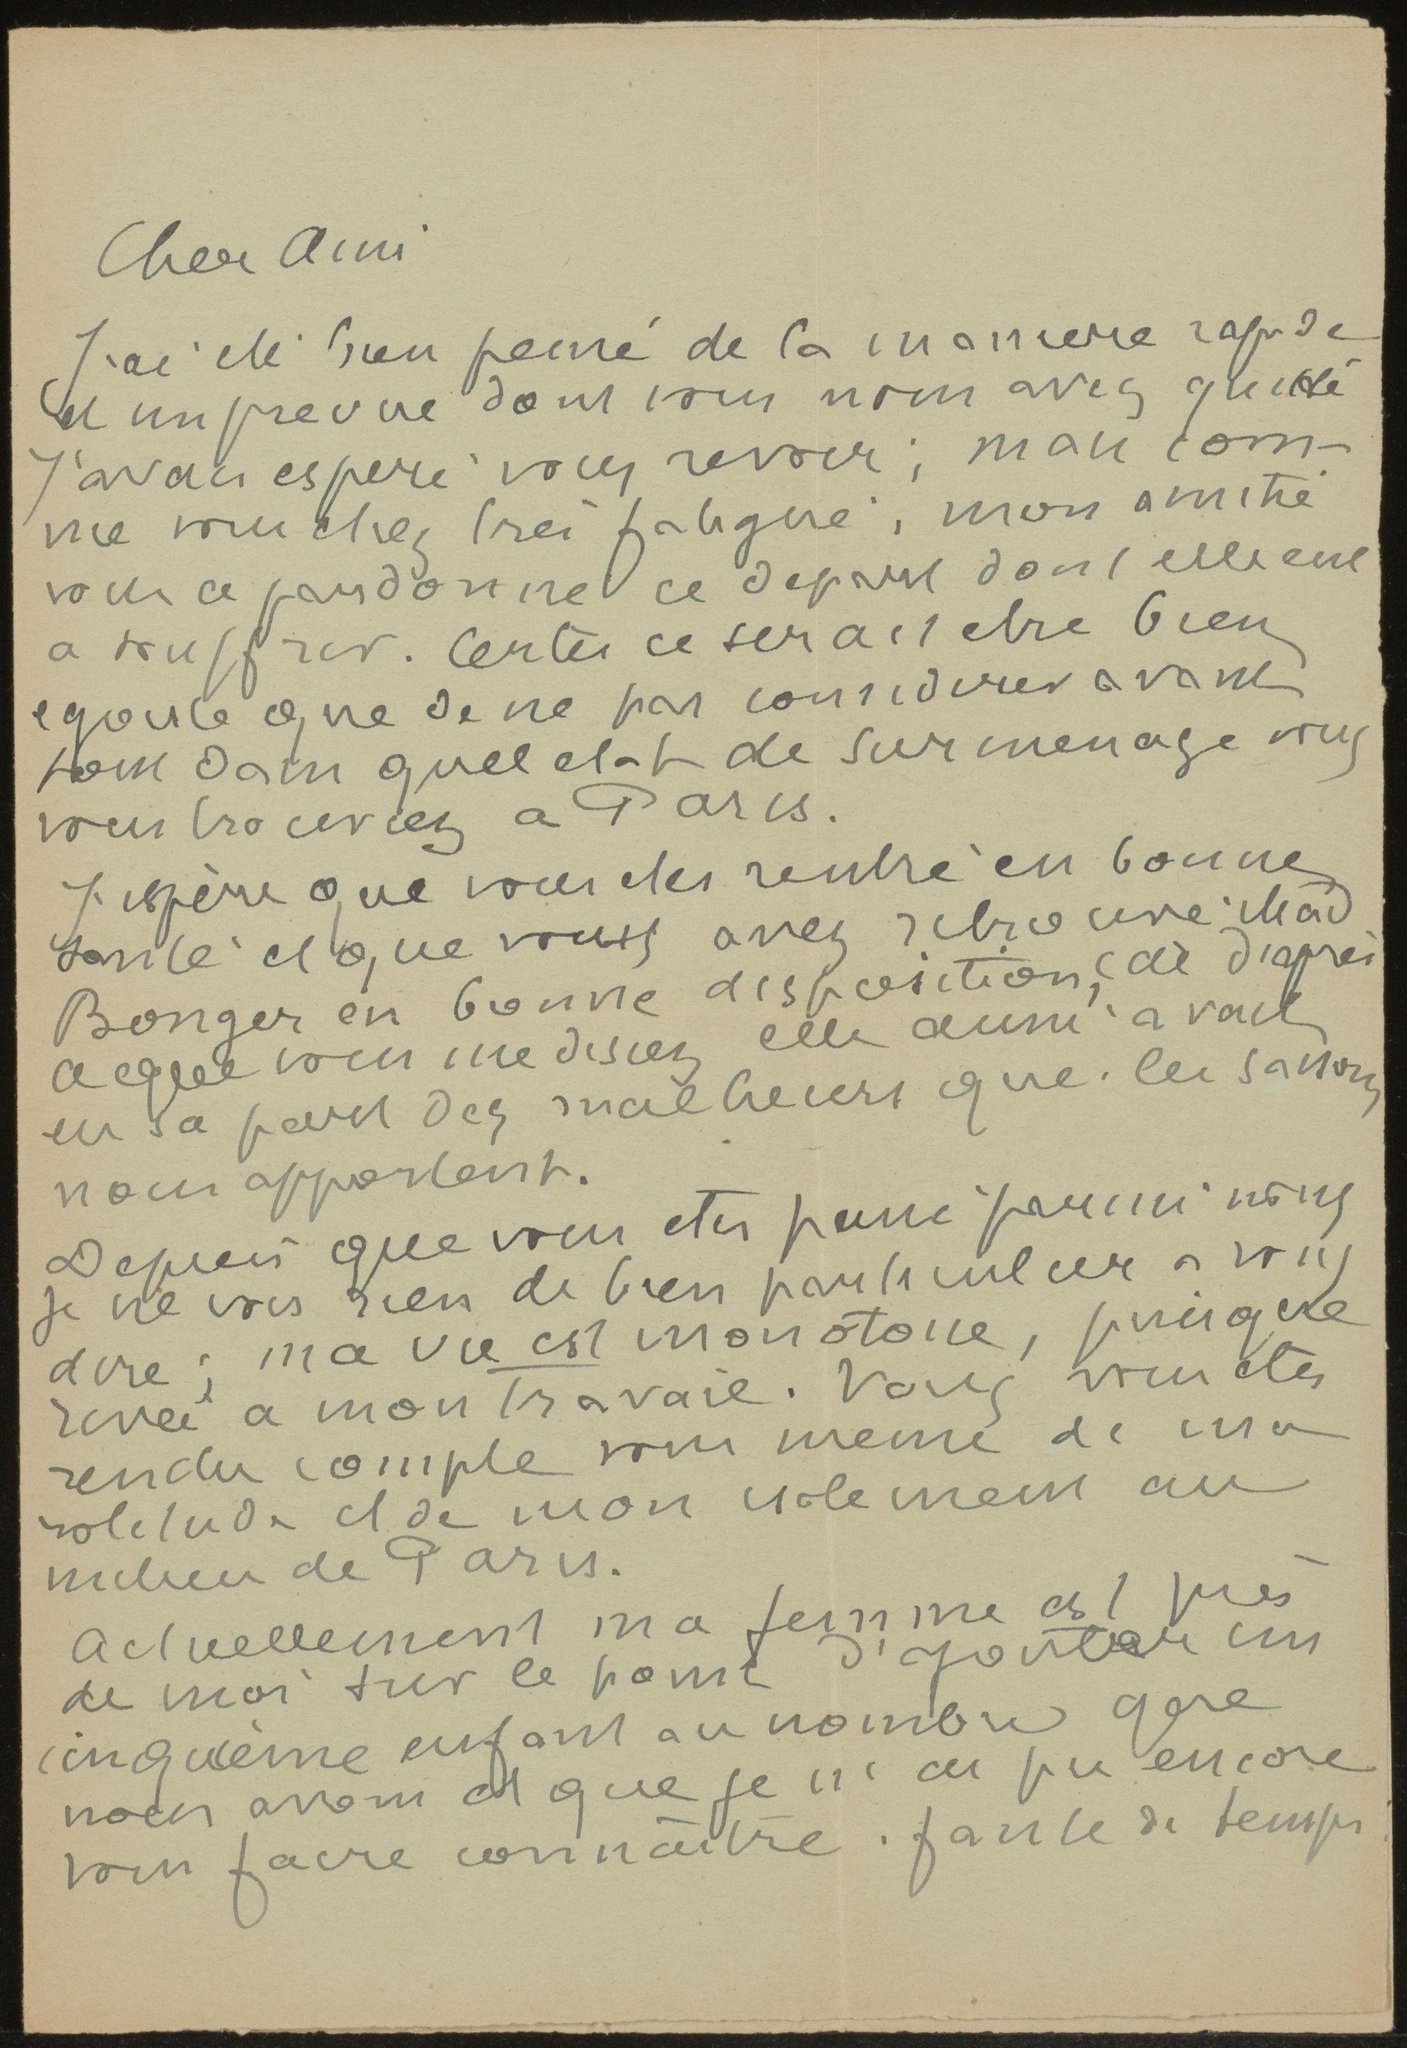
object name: letter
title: Brief aan Andries Bonger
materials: ink, paper, pencil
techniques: pen, writing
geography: paris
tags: amsterdam, andries bonger, anacapri, sculptor, saar de swart, family life, painting (including book-illumination, miniature-painting), historical persons (portraits and scenes from the life), paris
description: Brief bevat een blad met aantekeningen en prijzen.